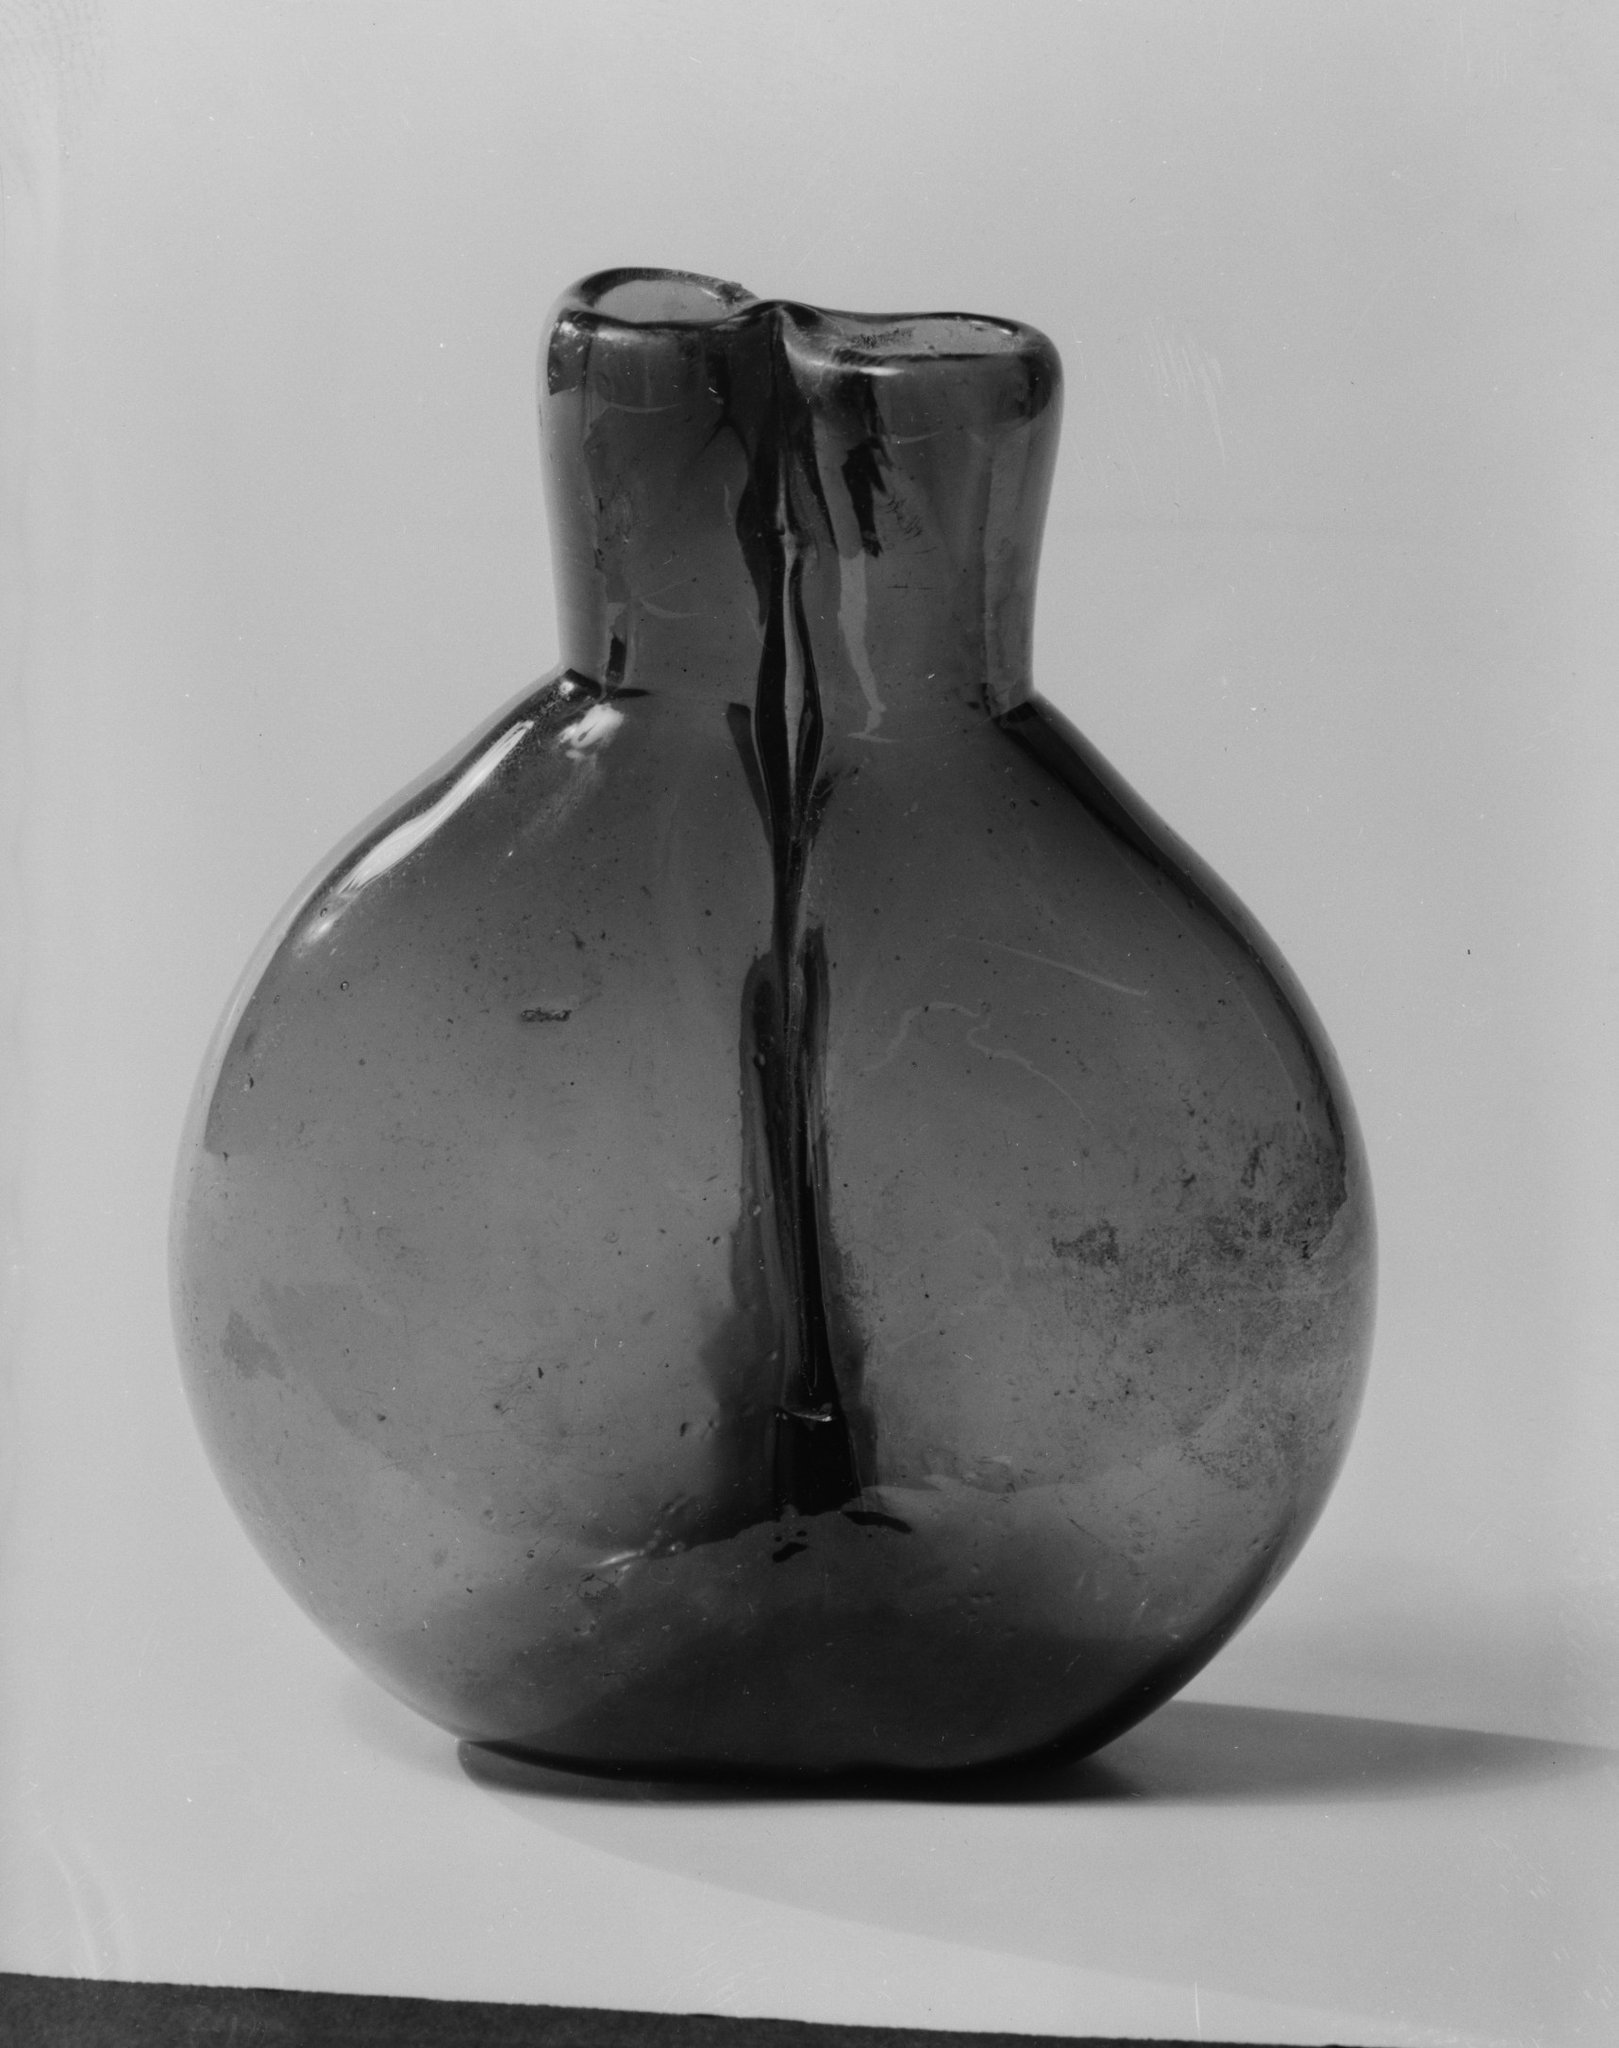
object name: gemel flask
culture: american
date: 1701-1800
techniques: glassblowing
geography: united states